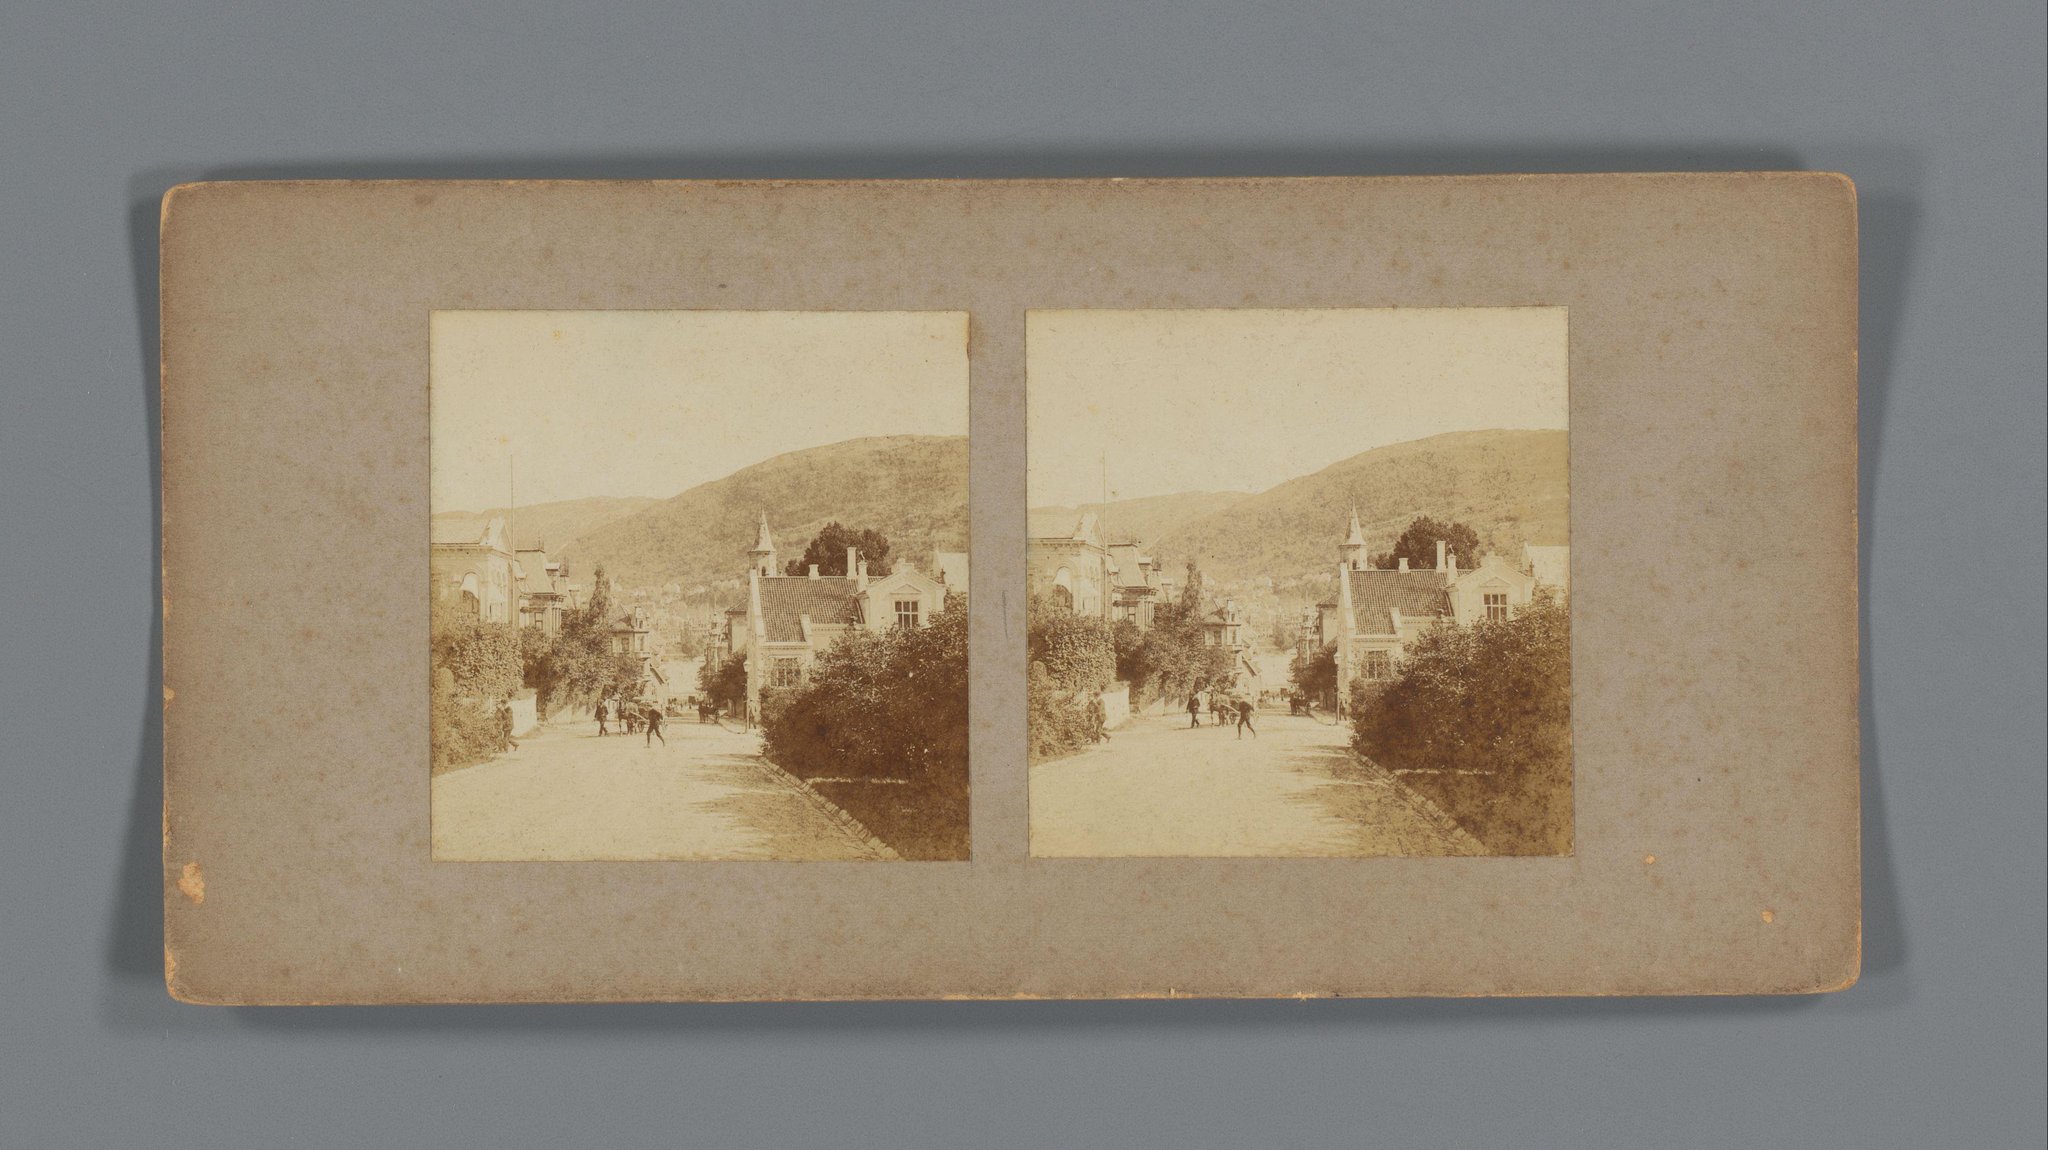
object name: stereograph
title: Gezicht op een straat in Bergen, Noorwegen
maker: Anonymous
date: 1882-1890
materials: cardboard, photographic support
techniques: gelatin silver print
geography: bergen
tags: rural housing, e.g. country-house, villa, cottage, street, mountains